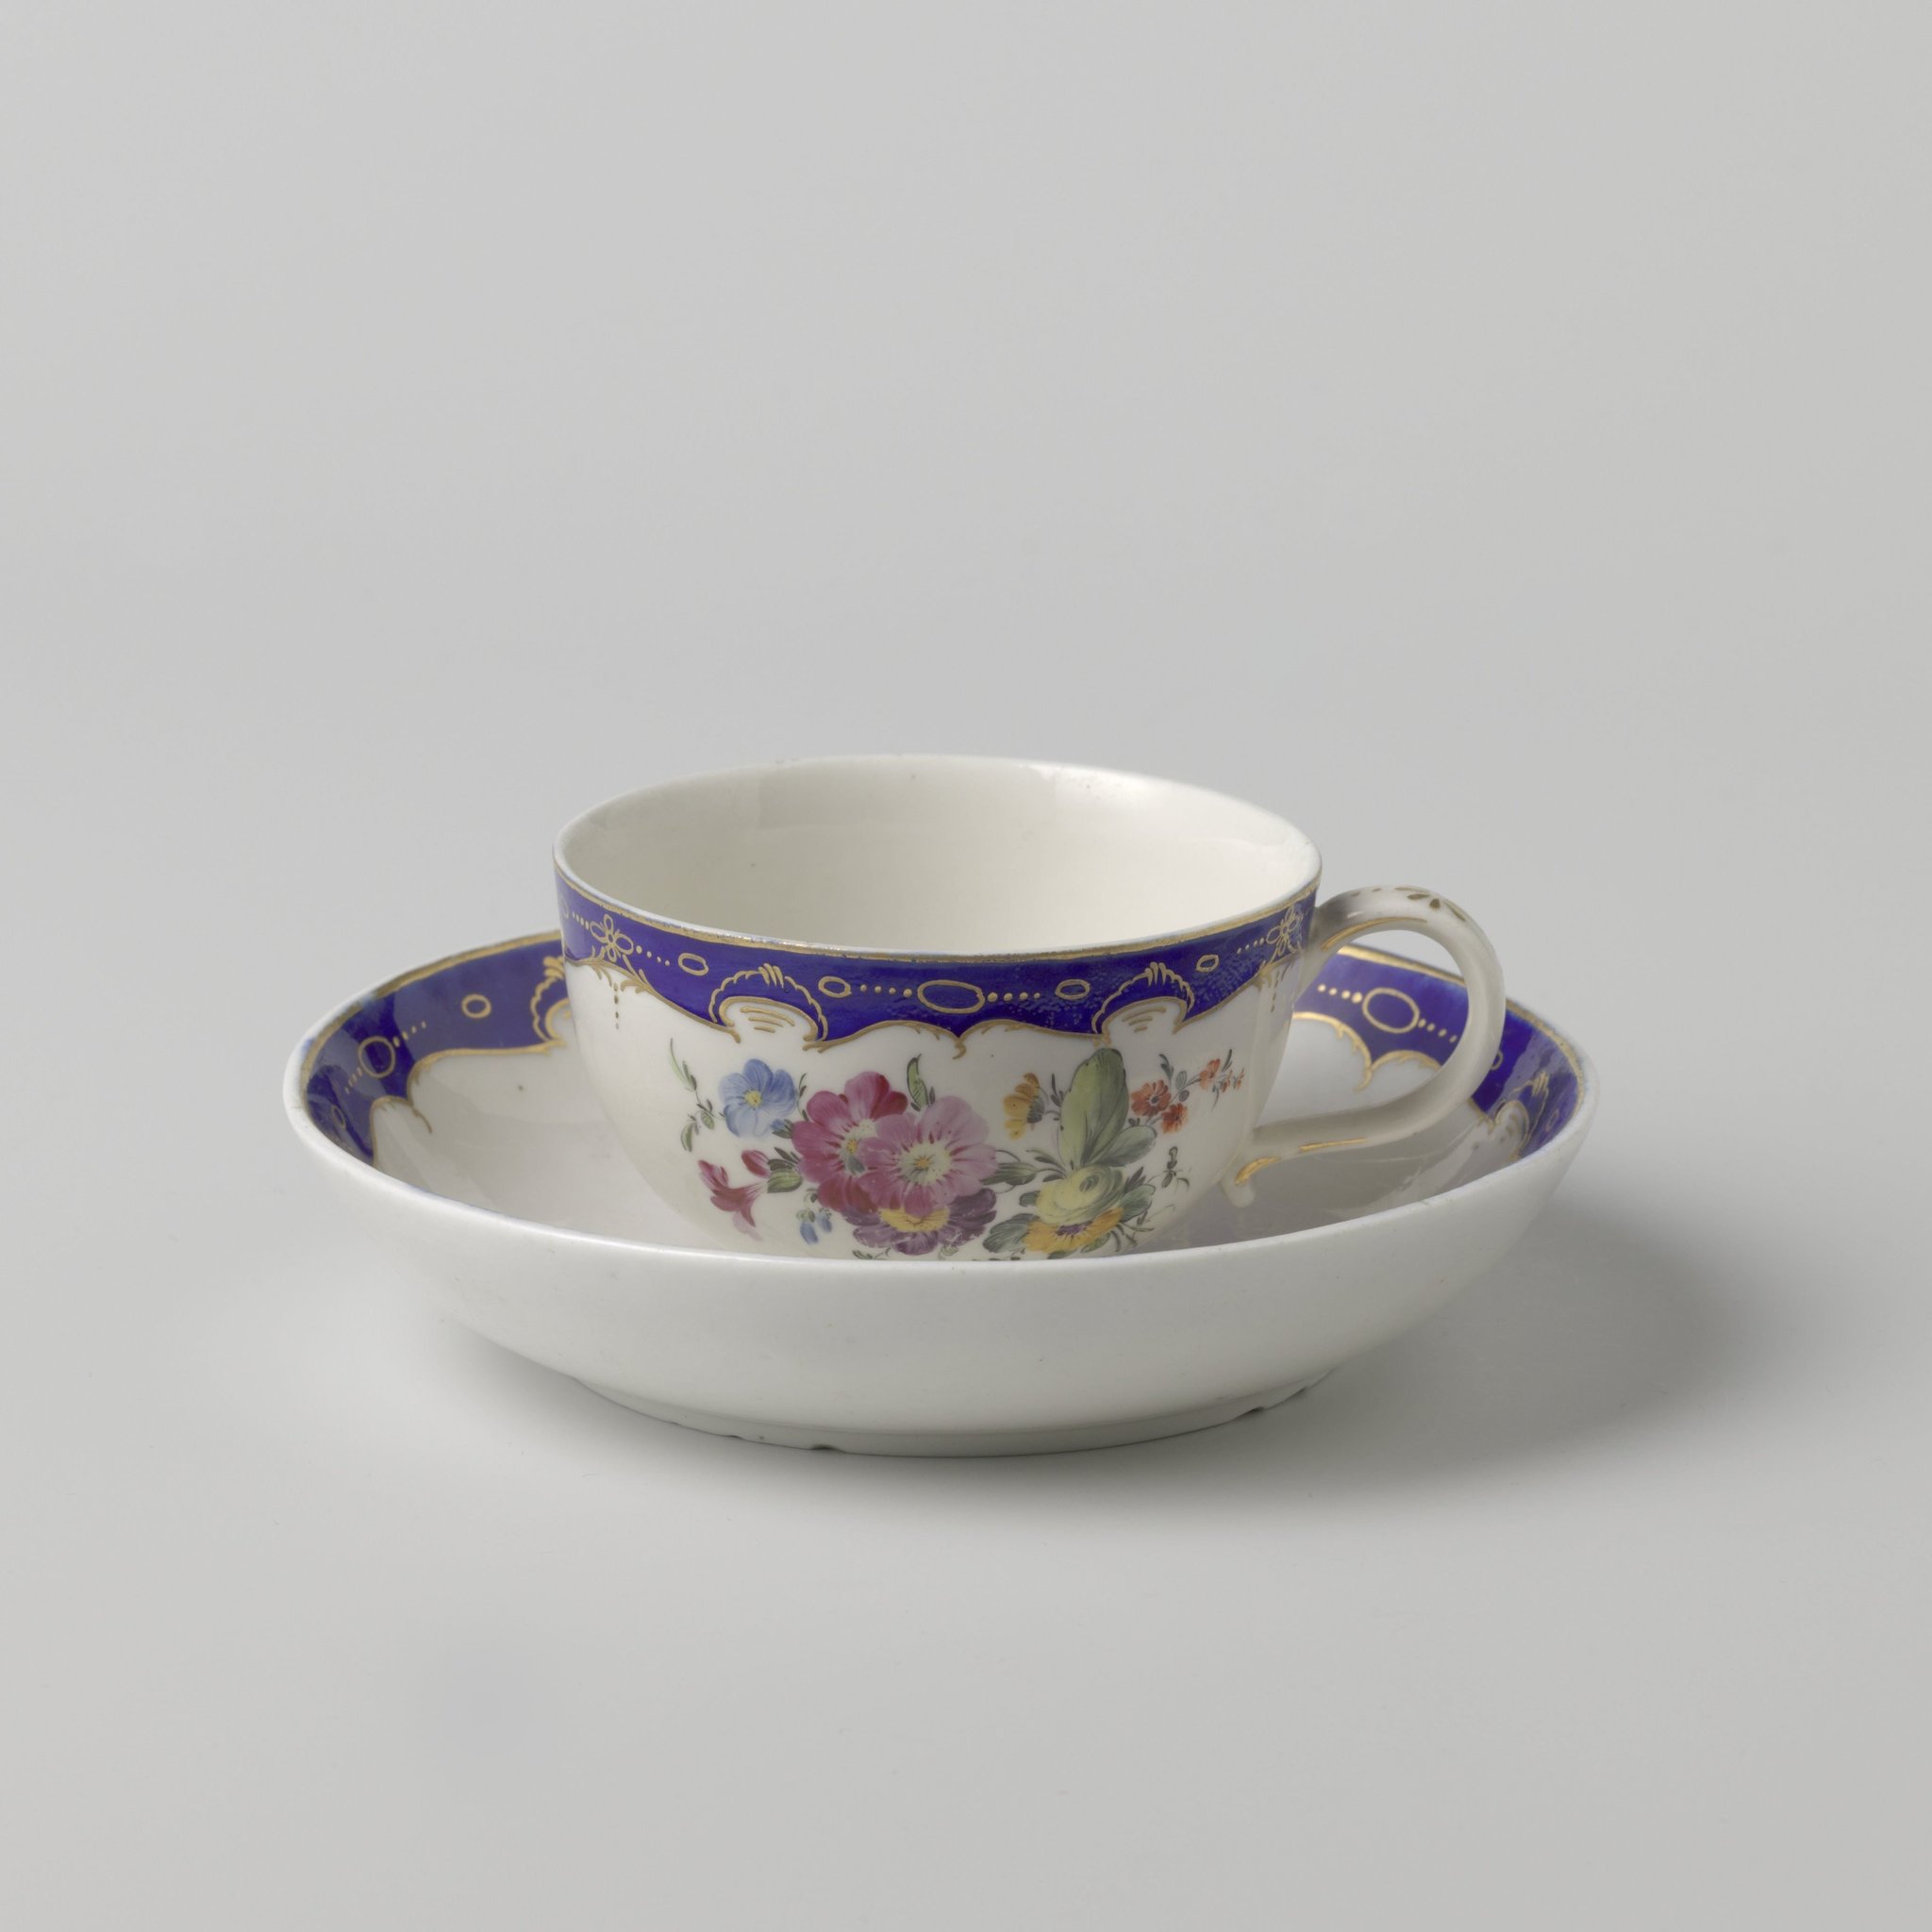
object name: platter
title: Schotel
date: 1777-1790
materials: porcelain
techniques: painted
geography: the hague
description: Schotel, onderdeel van theeservies. Op de rand een blauwe band met rocaille ornament. Het hoofdmotief bestaat uit een bloemboeket omgeven door strooibloemen. Gemerkt met een ooievaar in bovenglazuurblauw. N.B. Doorniks zacht porselein beschilderd te Den Haag.